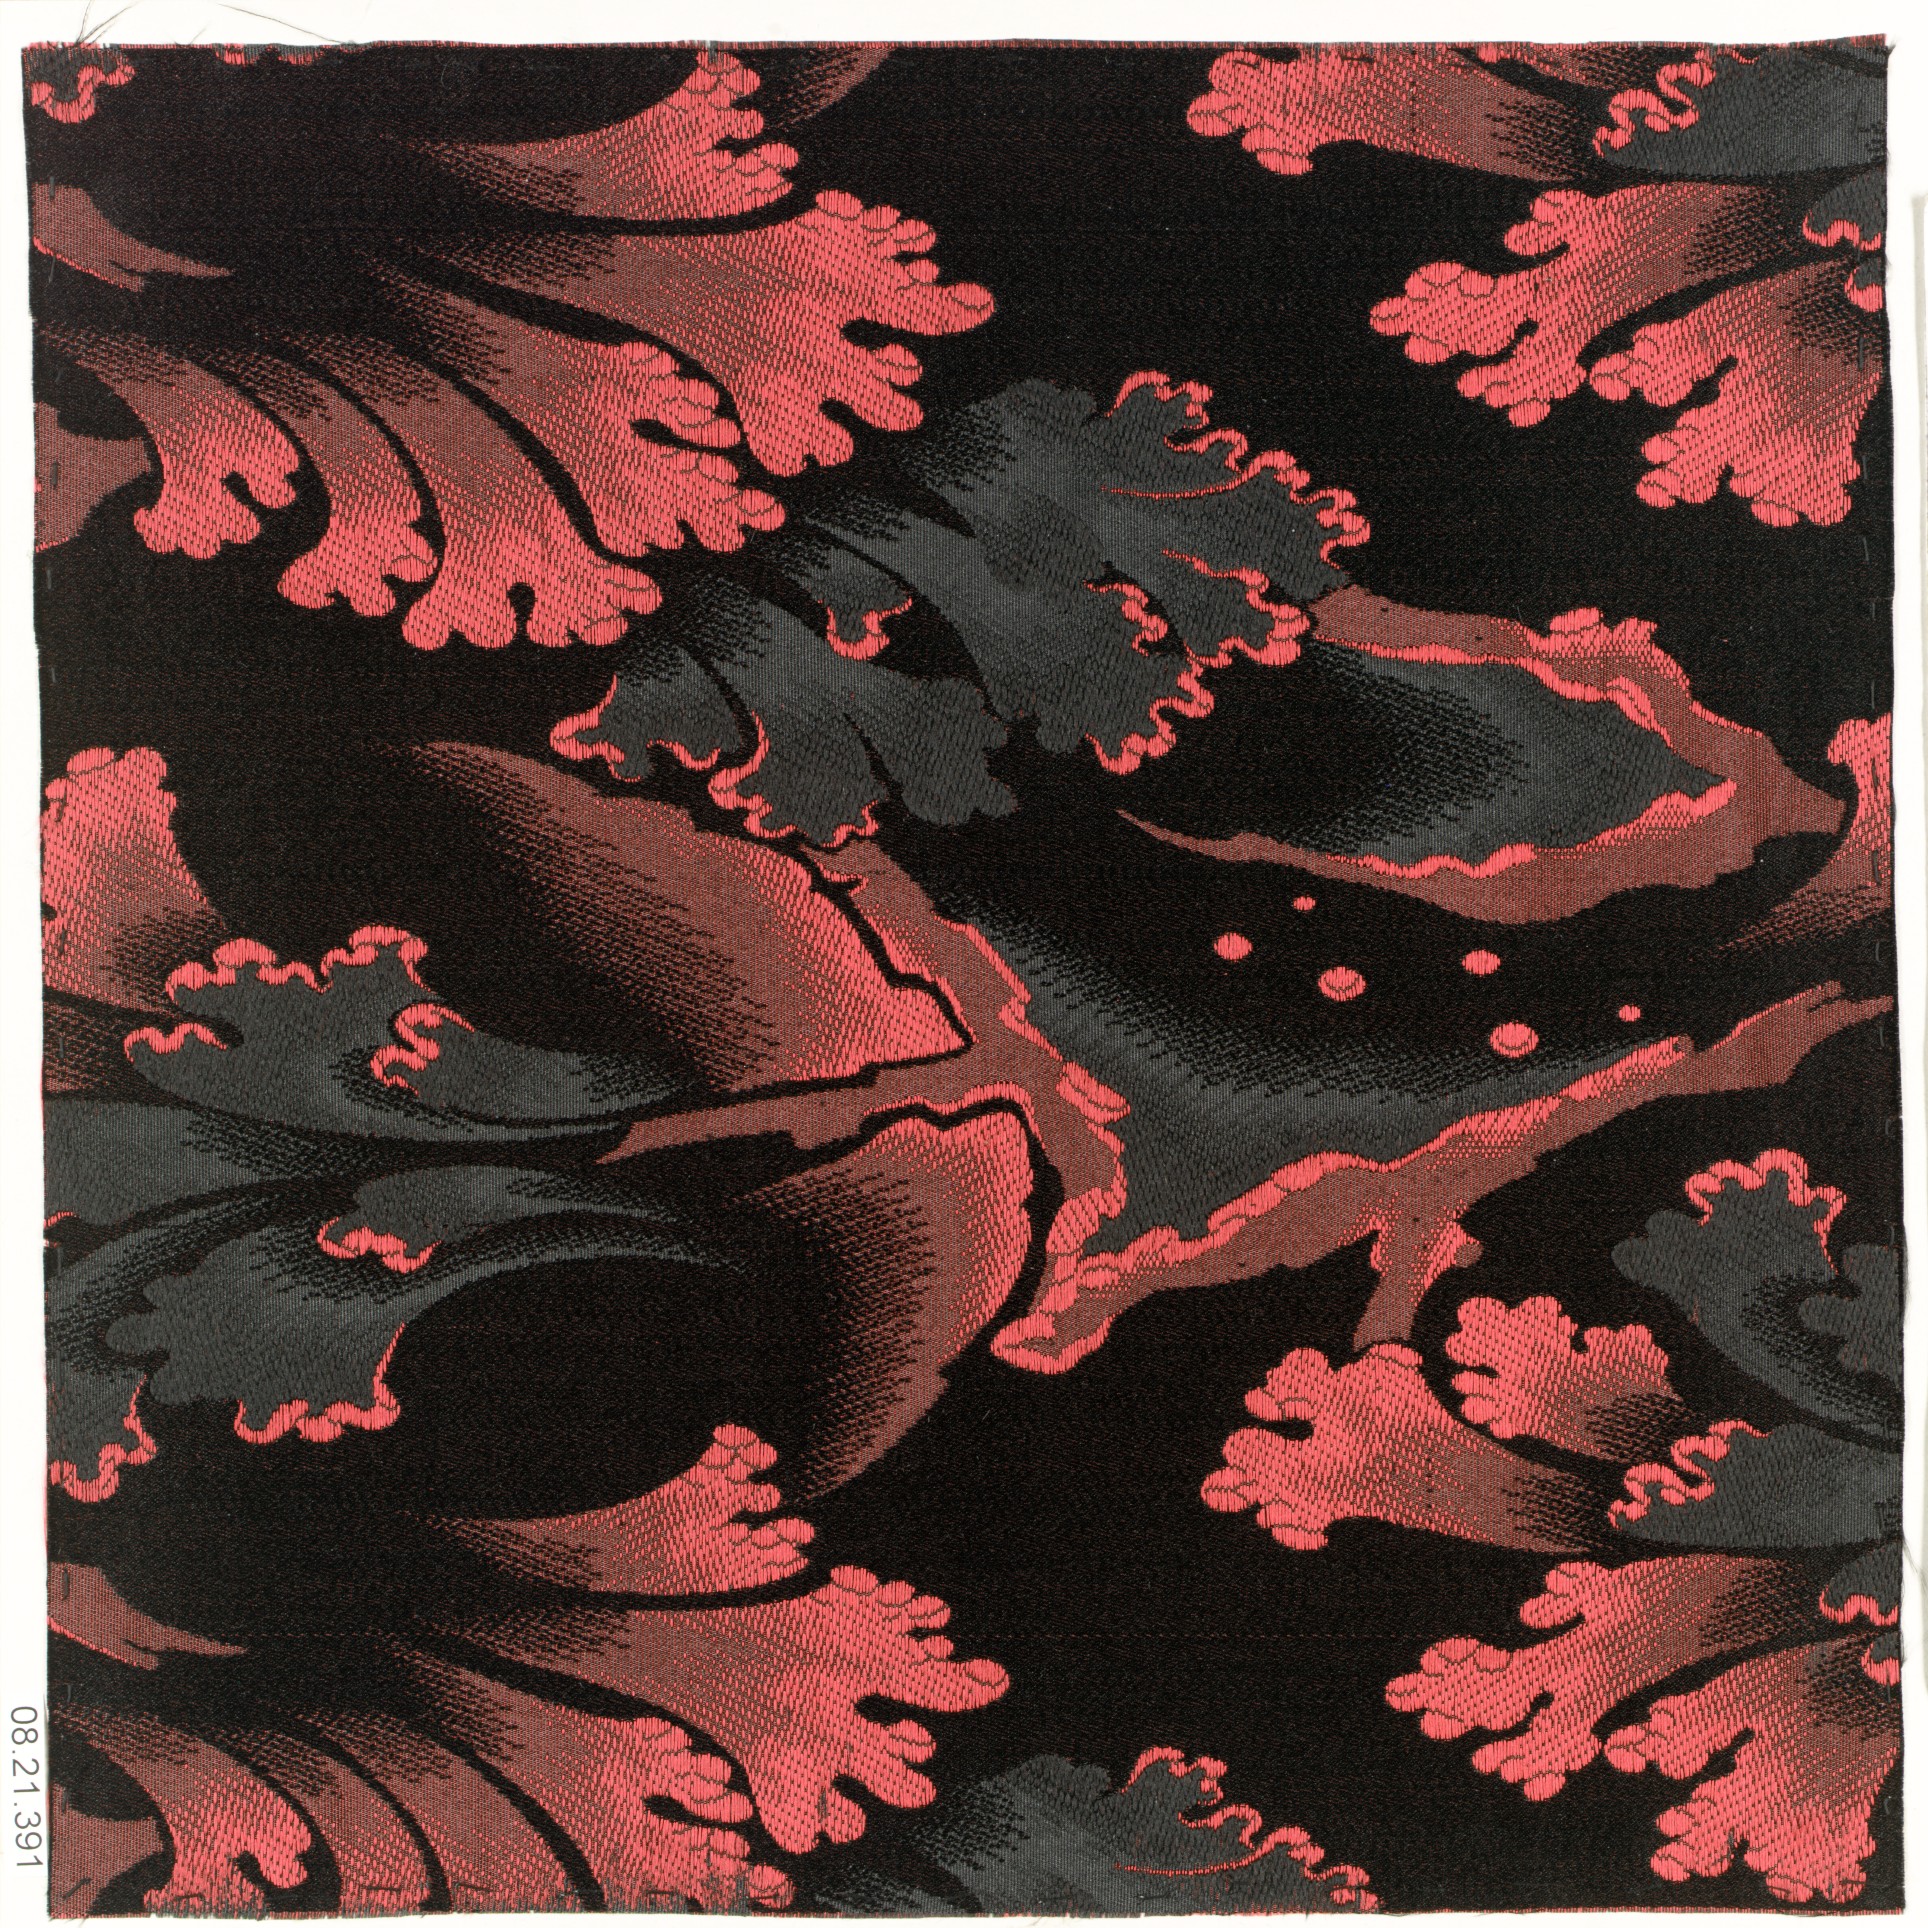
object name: textile sample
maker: Anonymous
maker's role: designer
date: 1900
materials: silk